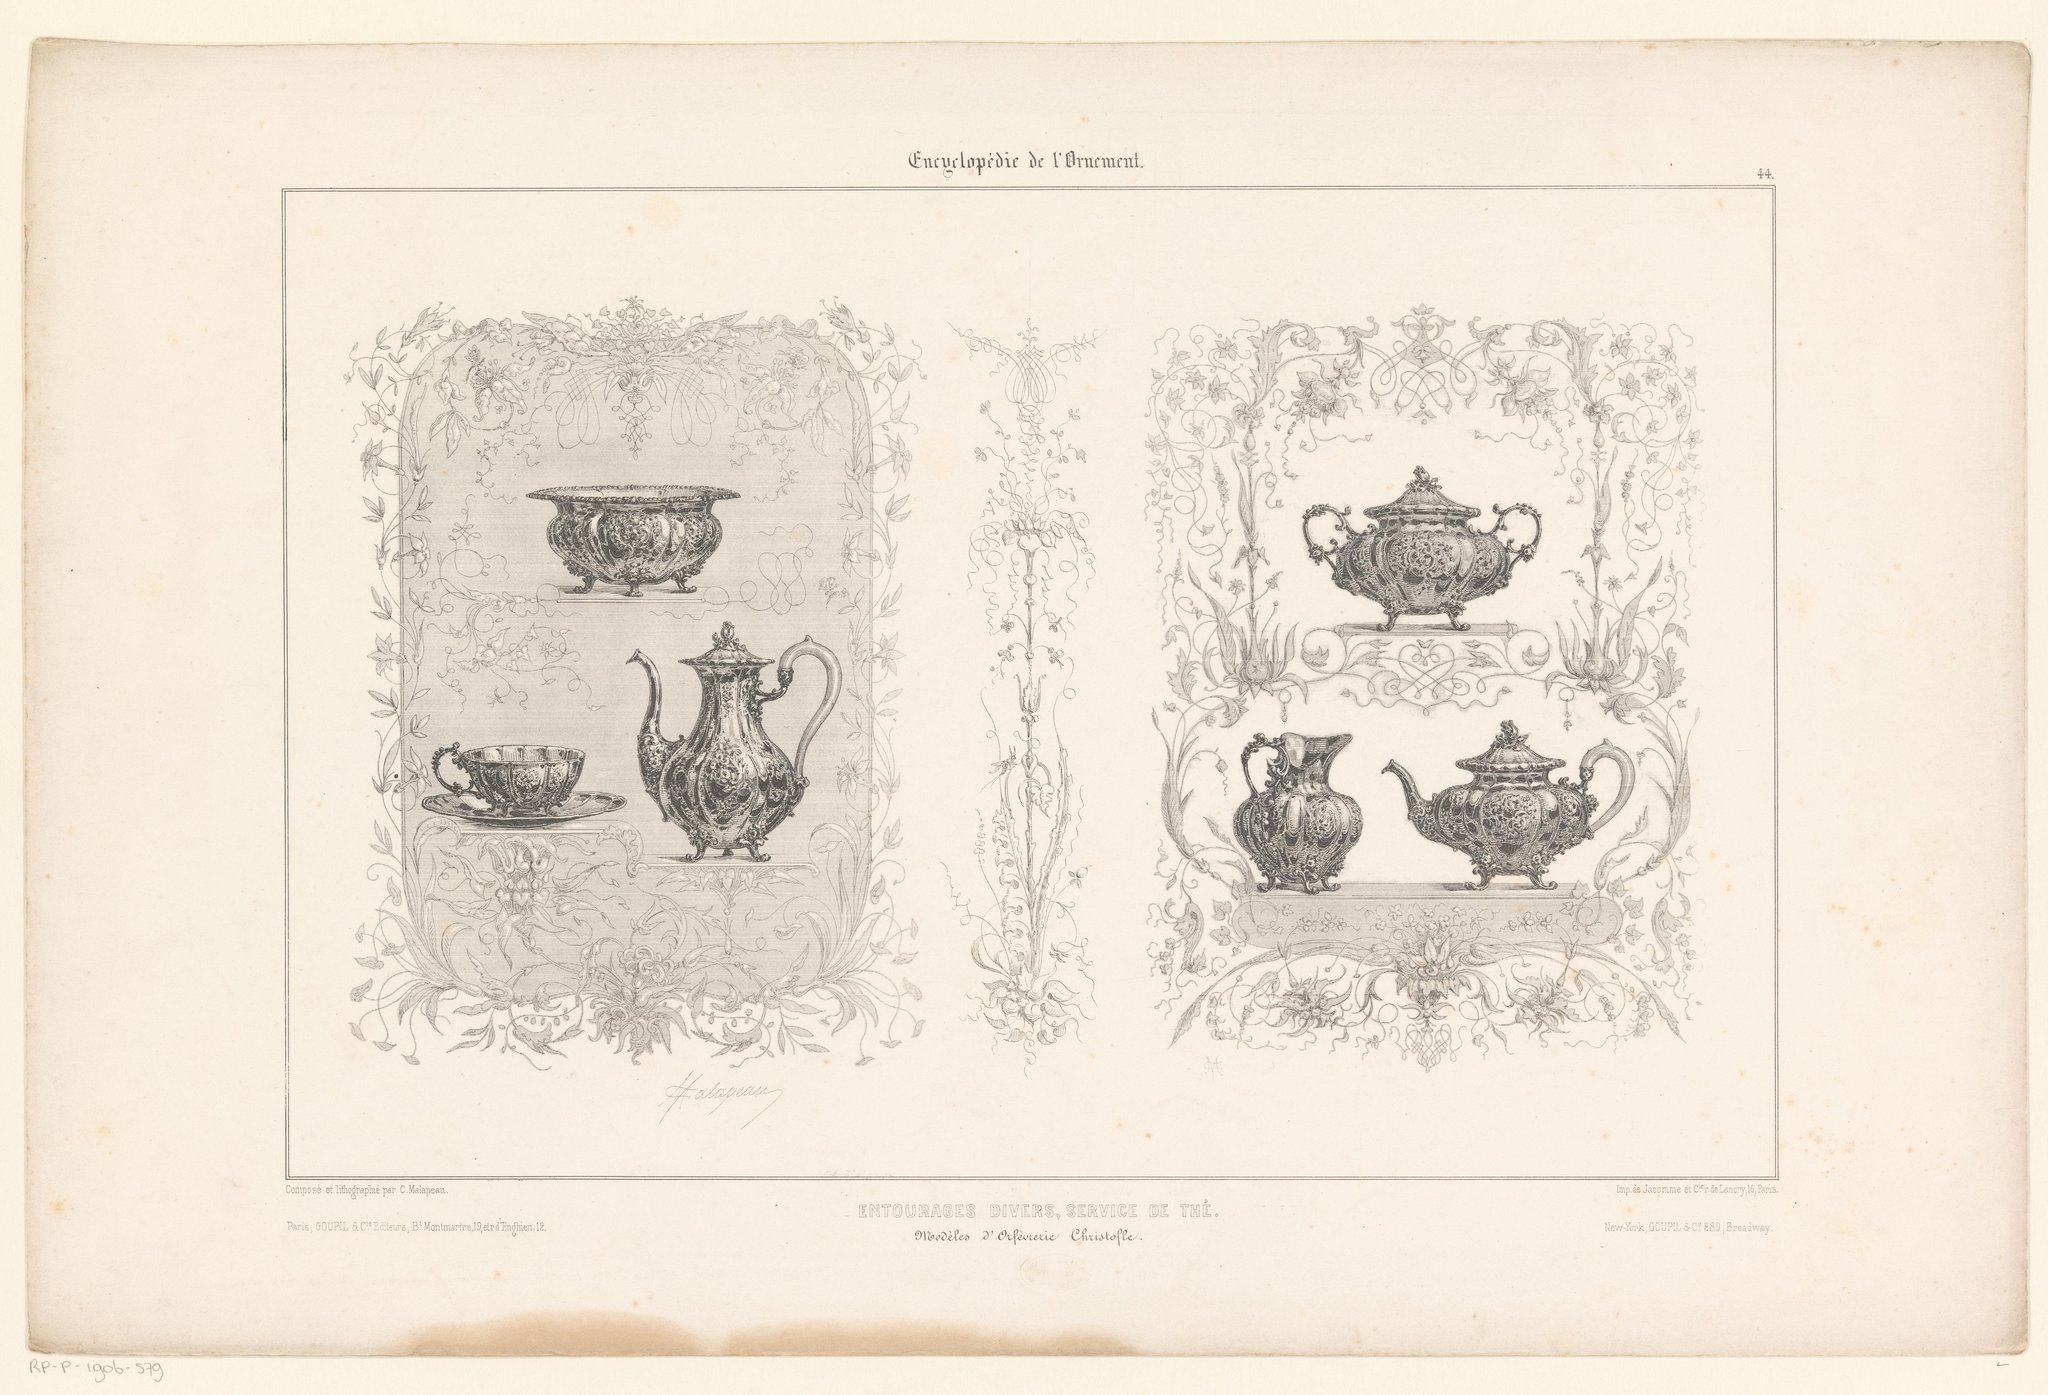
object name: print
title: Encyclopédie de l'Ornement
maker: claude nicolas malapeau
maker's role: print maker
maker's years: 1755-1803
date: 1850-1860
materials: paper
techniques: lithograph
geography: new york city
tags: tea- and coffee-service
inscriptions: collector's mark: Lugt 2228, check stamp: ‘Goupil, Vibert & C / Editeurs / A Paris’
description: Links een pot, een theekop op schotel en een theekan met deksel in een ornamentele omlijsting. Rechts een pot met deksel, een kan en een theekan met deksel in een ornamentele omlijsting.